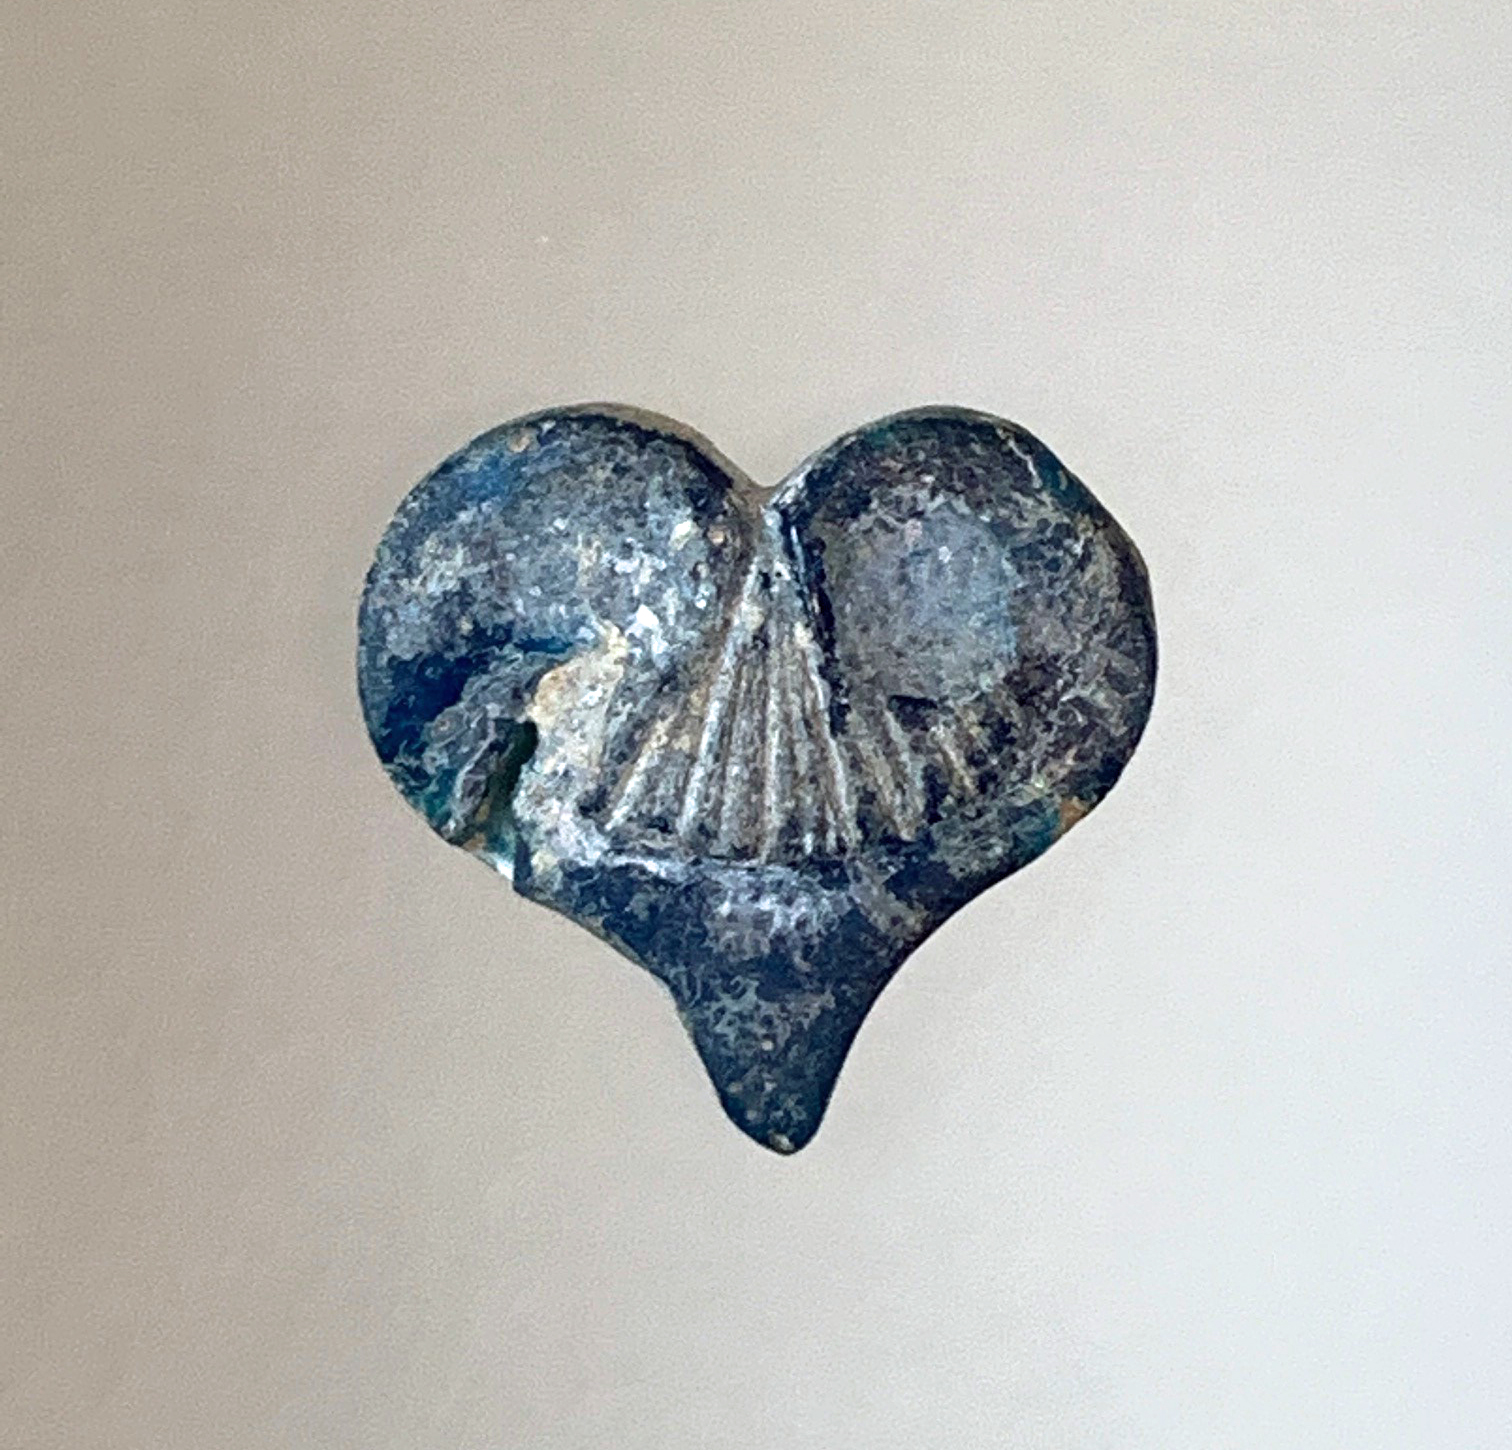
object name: ornament in the form of an ivy leaf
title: Glass ornament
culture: aegean, helladic or mycenaean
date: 1370-1200 BCE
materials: glass